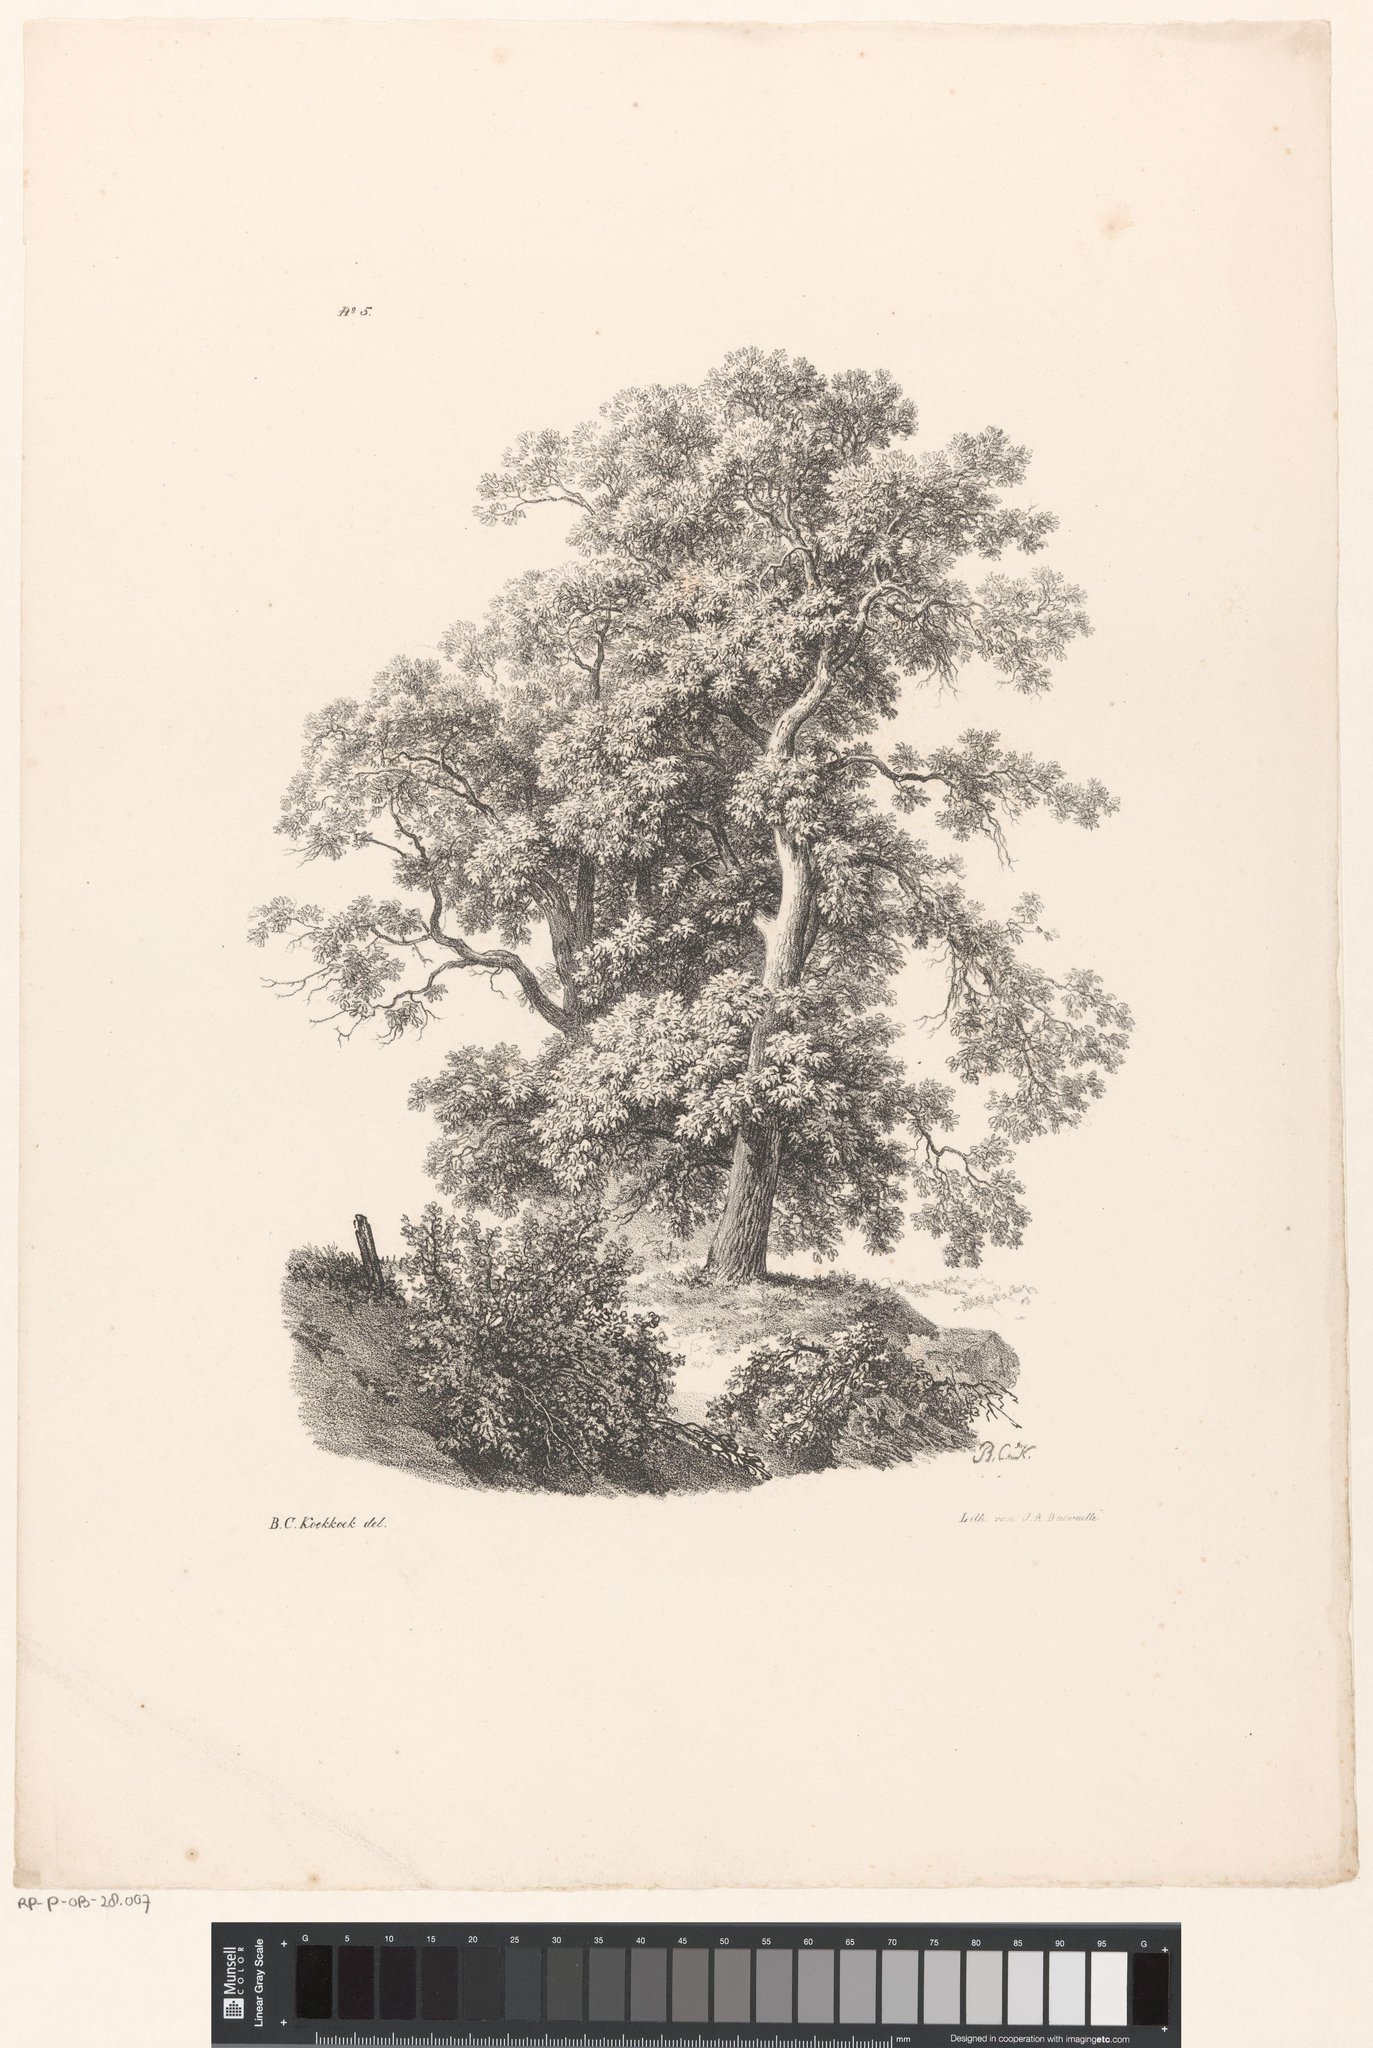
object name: print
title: Bomen en struiken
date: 1829-1830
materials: paper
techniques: lithograph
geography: amsterdam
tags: shrubs, groups of trees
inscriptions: collector's mark: Lugt 2228